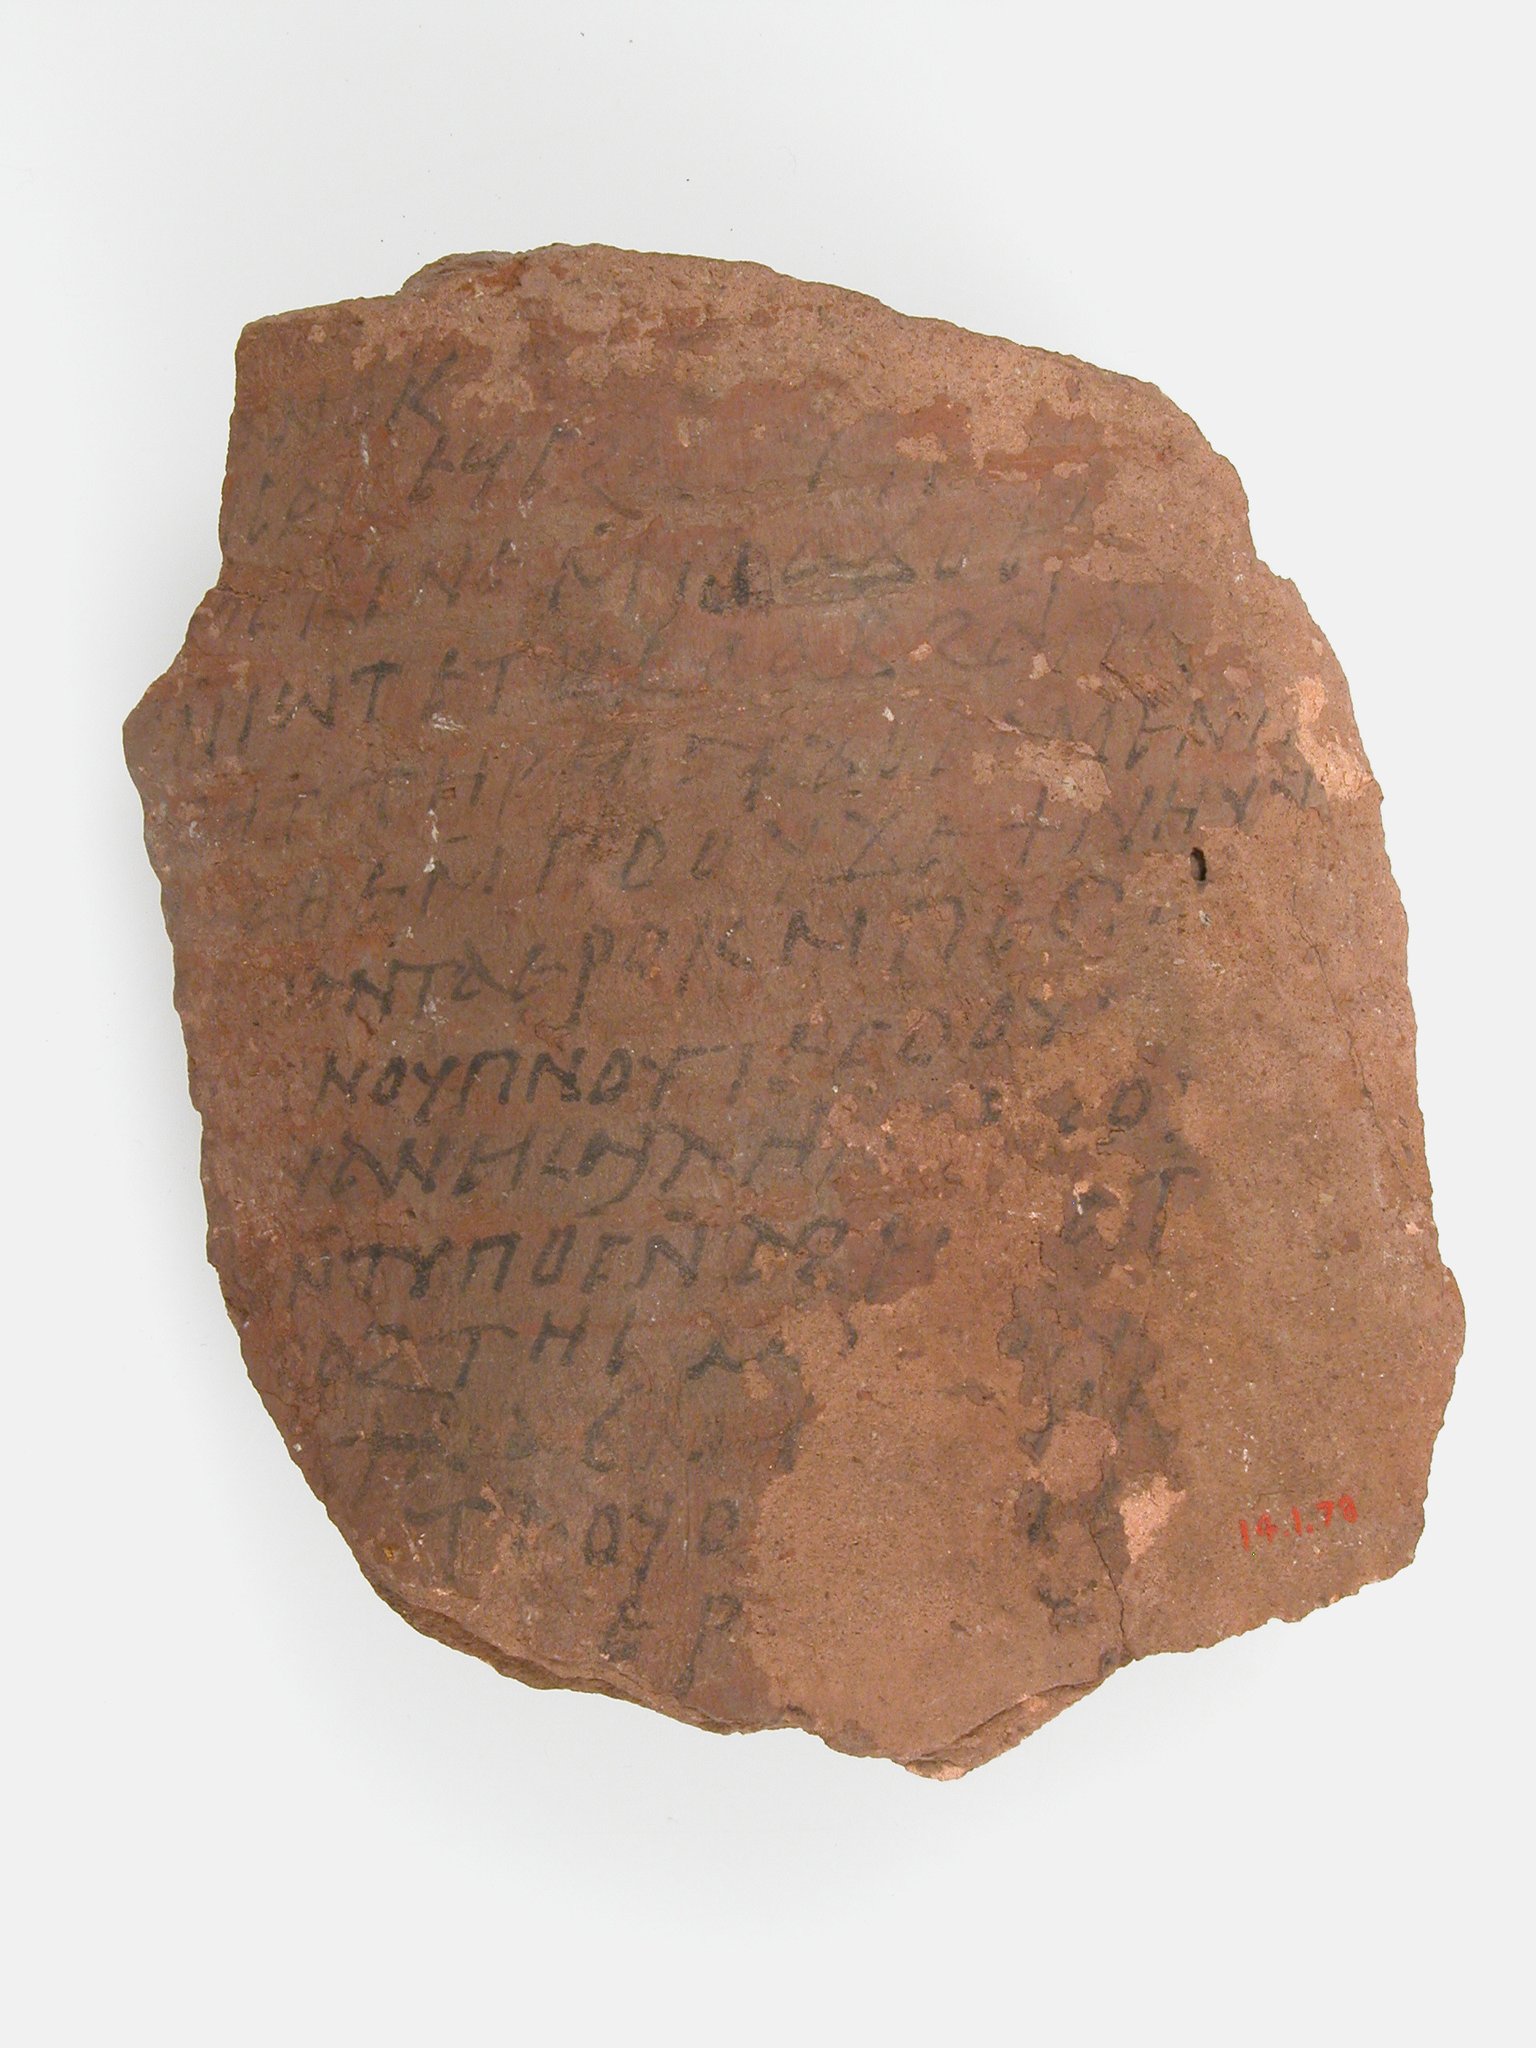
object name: ostrakon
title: Ostrakon with a Letter from Isaac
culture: coptic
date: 600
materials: ink, pottery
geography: egypt